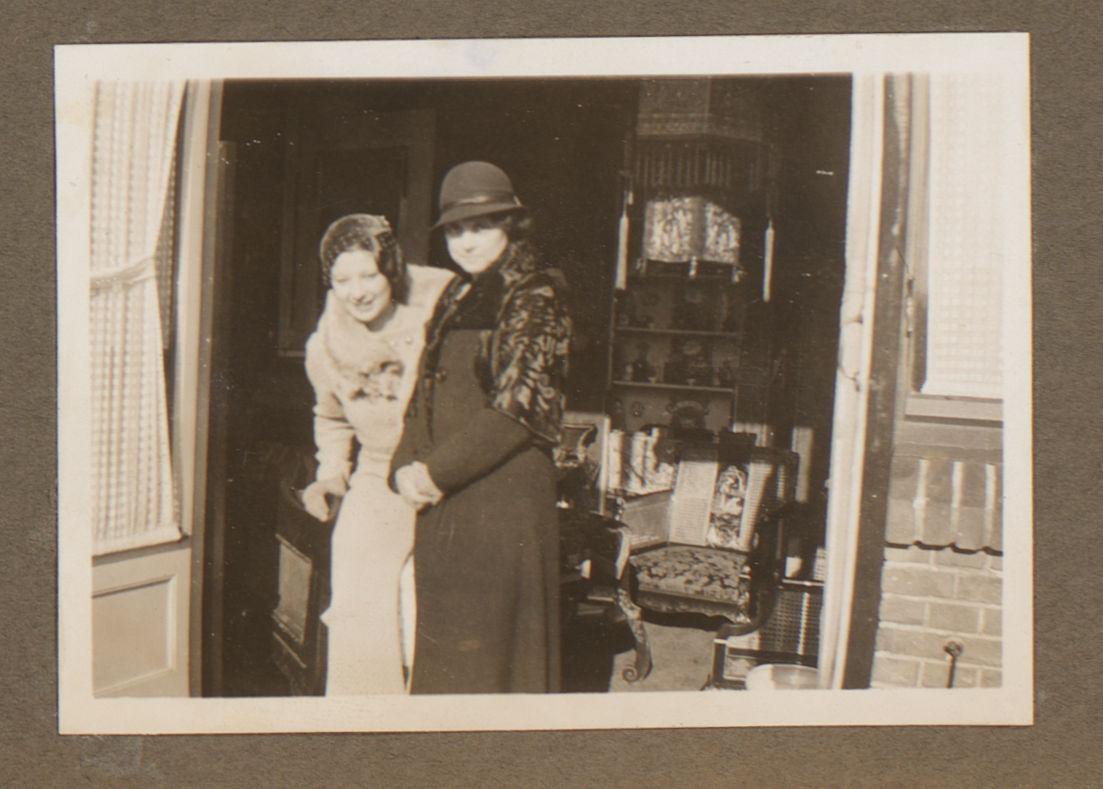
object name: photograph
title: Wilhelmina van Zijll de Jong en en haar moeder Henriëtte Wassink in een huis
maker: Anonymous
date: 1907-1932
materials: paper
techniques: gelatin silver print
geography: scheveningen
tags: batavia, henriëtte wassink, the hague, wilhelmina van zijll de jong, historical persons - bb - woman